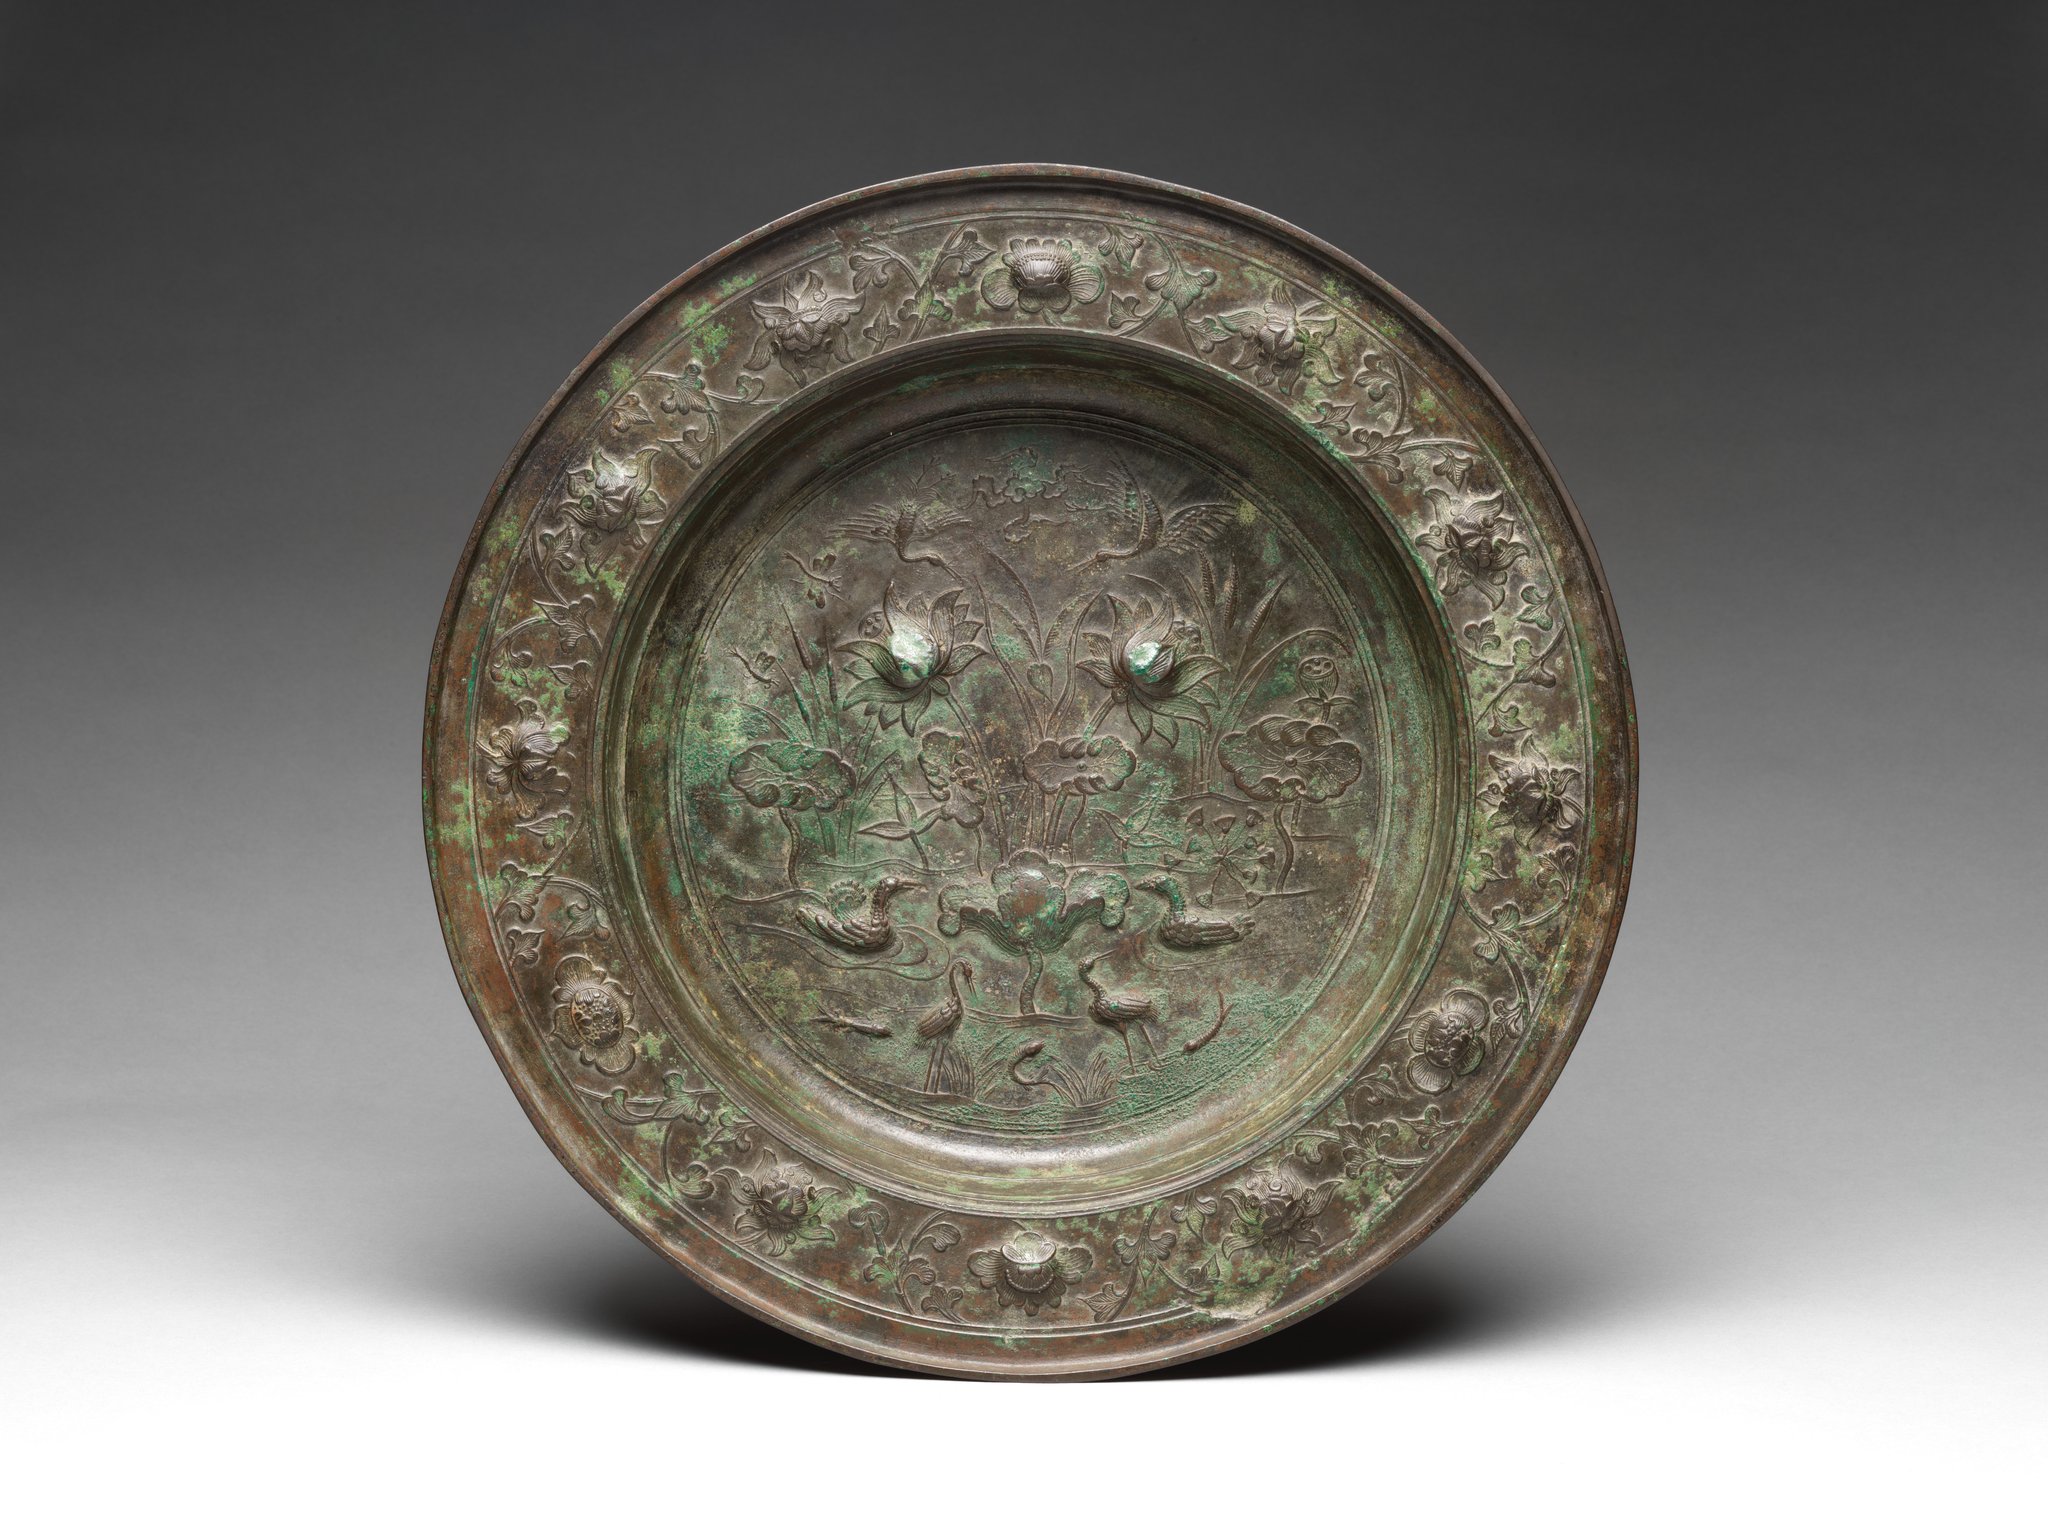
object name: basin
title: Basin with birds in a lotus pond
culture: chinese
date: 1301-1400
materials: copper alloy